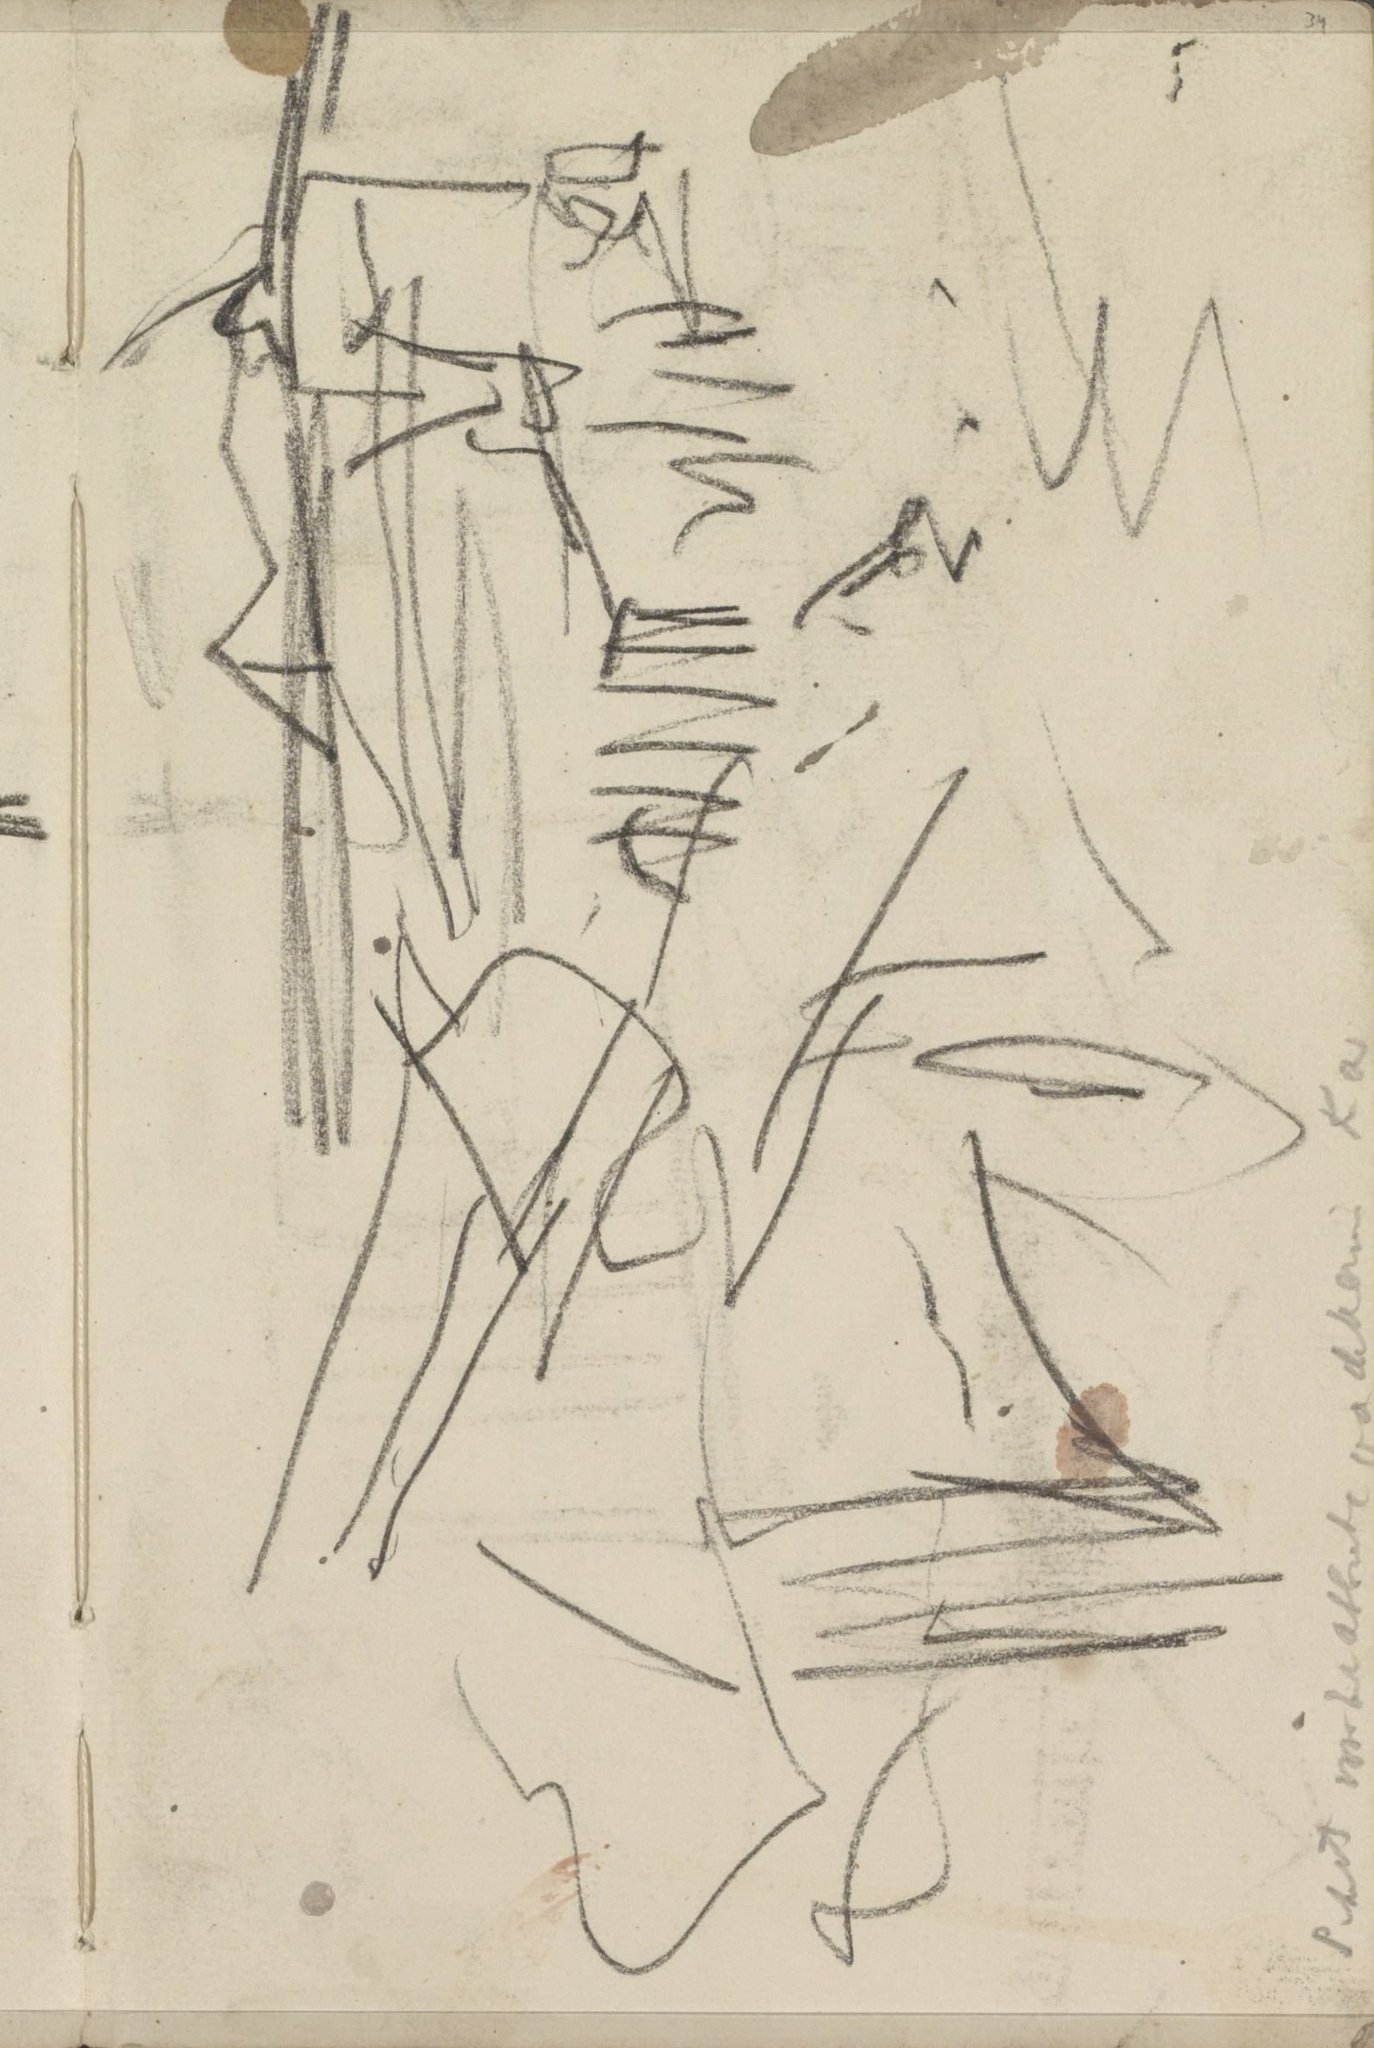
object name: sketchbook leaf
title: Studieblad met een kar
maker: george hendrik breitner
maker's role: draughtsman, painter, print maker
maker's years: 1857-1923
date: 1881-1883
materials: chalk, paper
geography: rotterdam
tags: (farm) wagon, freight wagon, cart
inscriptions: annotation: ‘Schets met de afbraak van de kermis Kar’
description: Pagina 34 uit een schetsboek met 19 bladen.